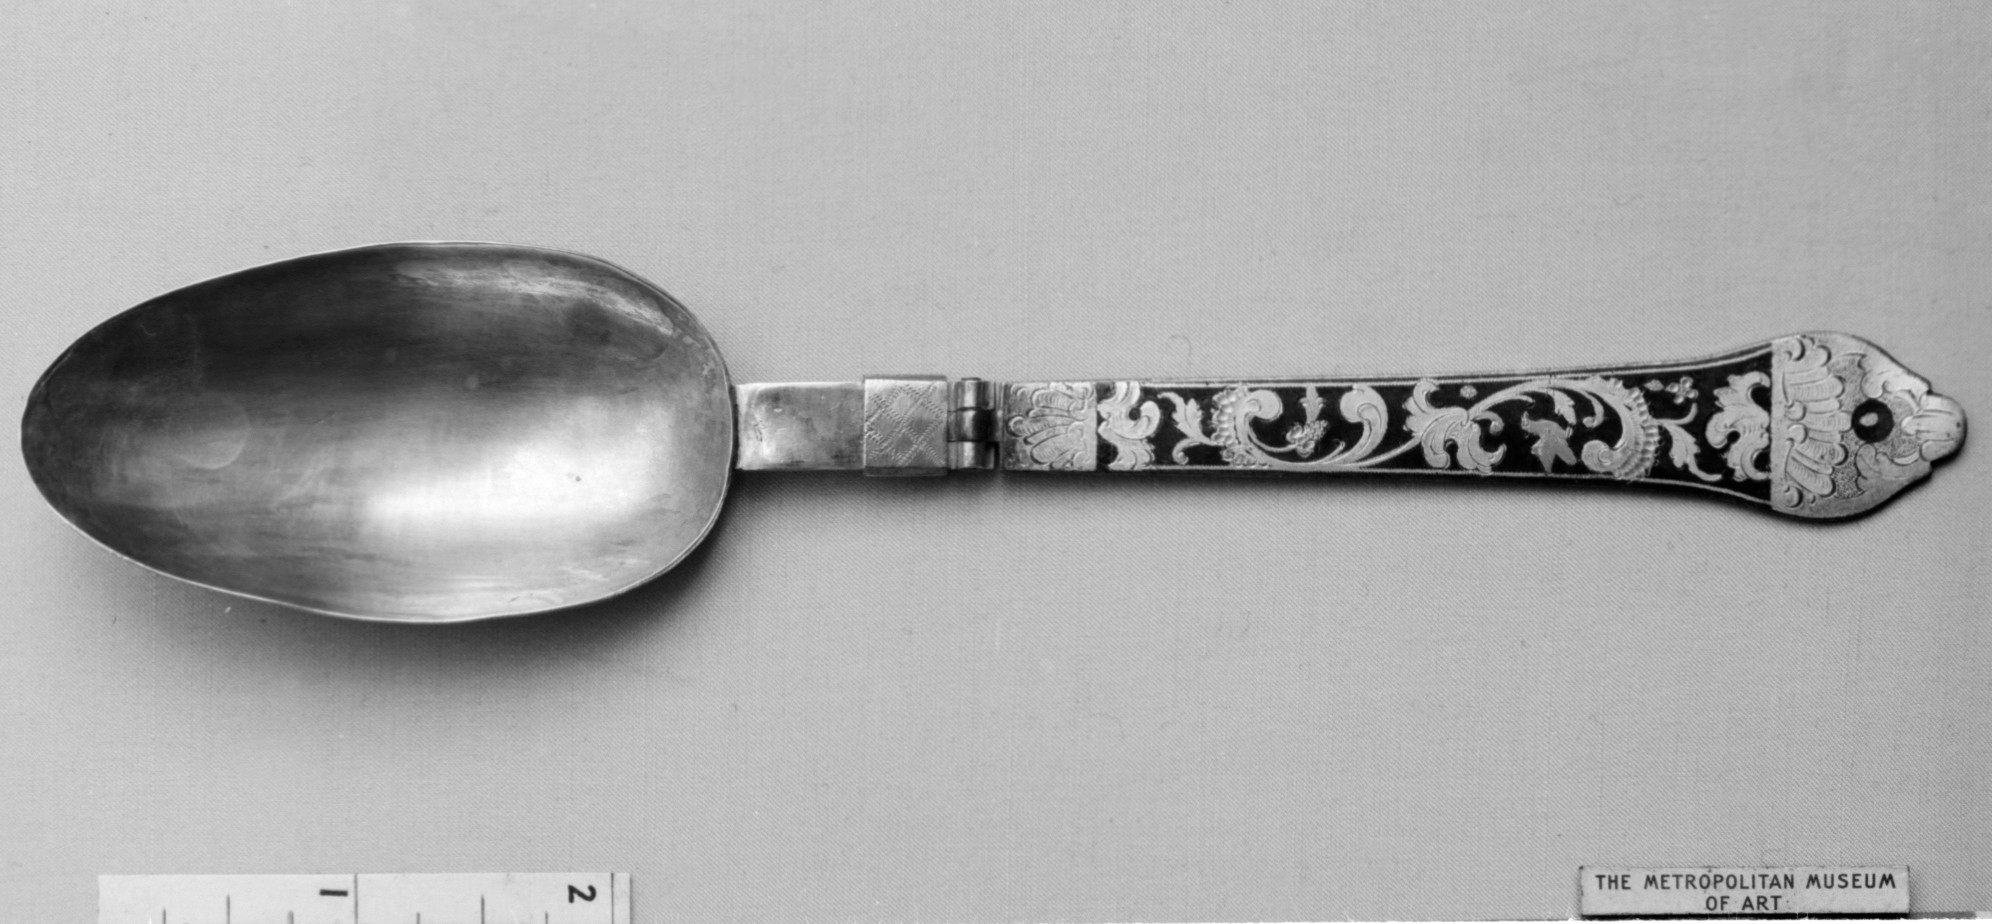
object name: trifid spoon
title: Trifid folding spoon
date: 1667-1733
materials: gilt copper, gold, niello, silver, steel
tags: birds